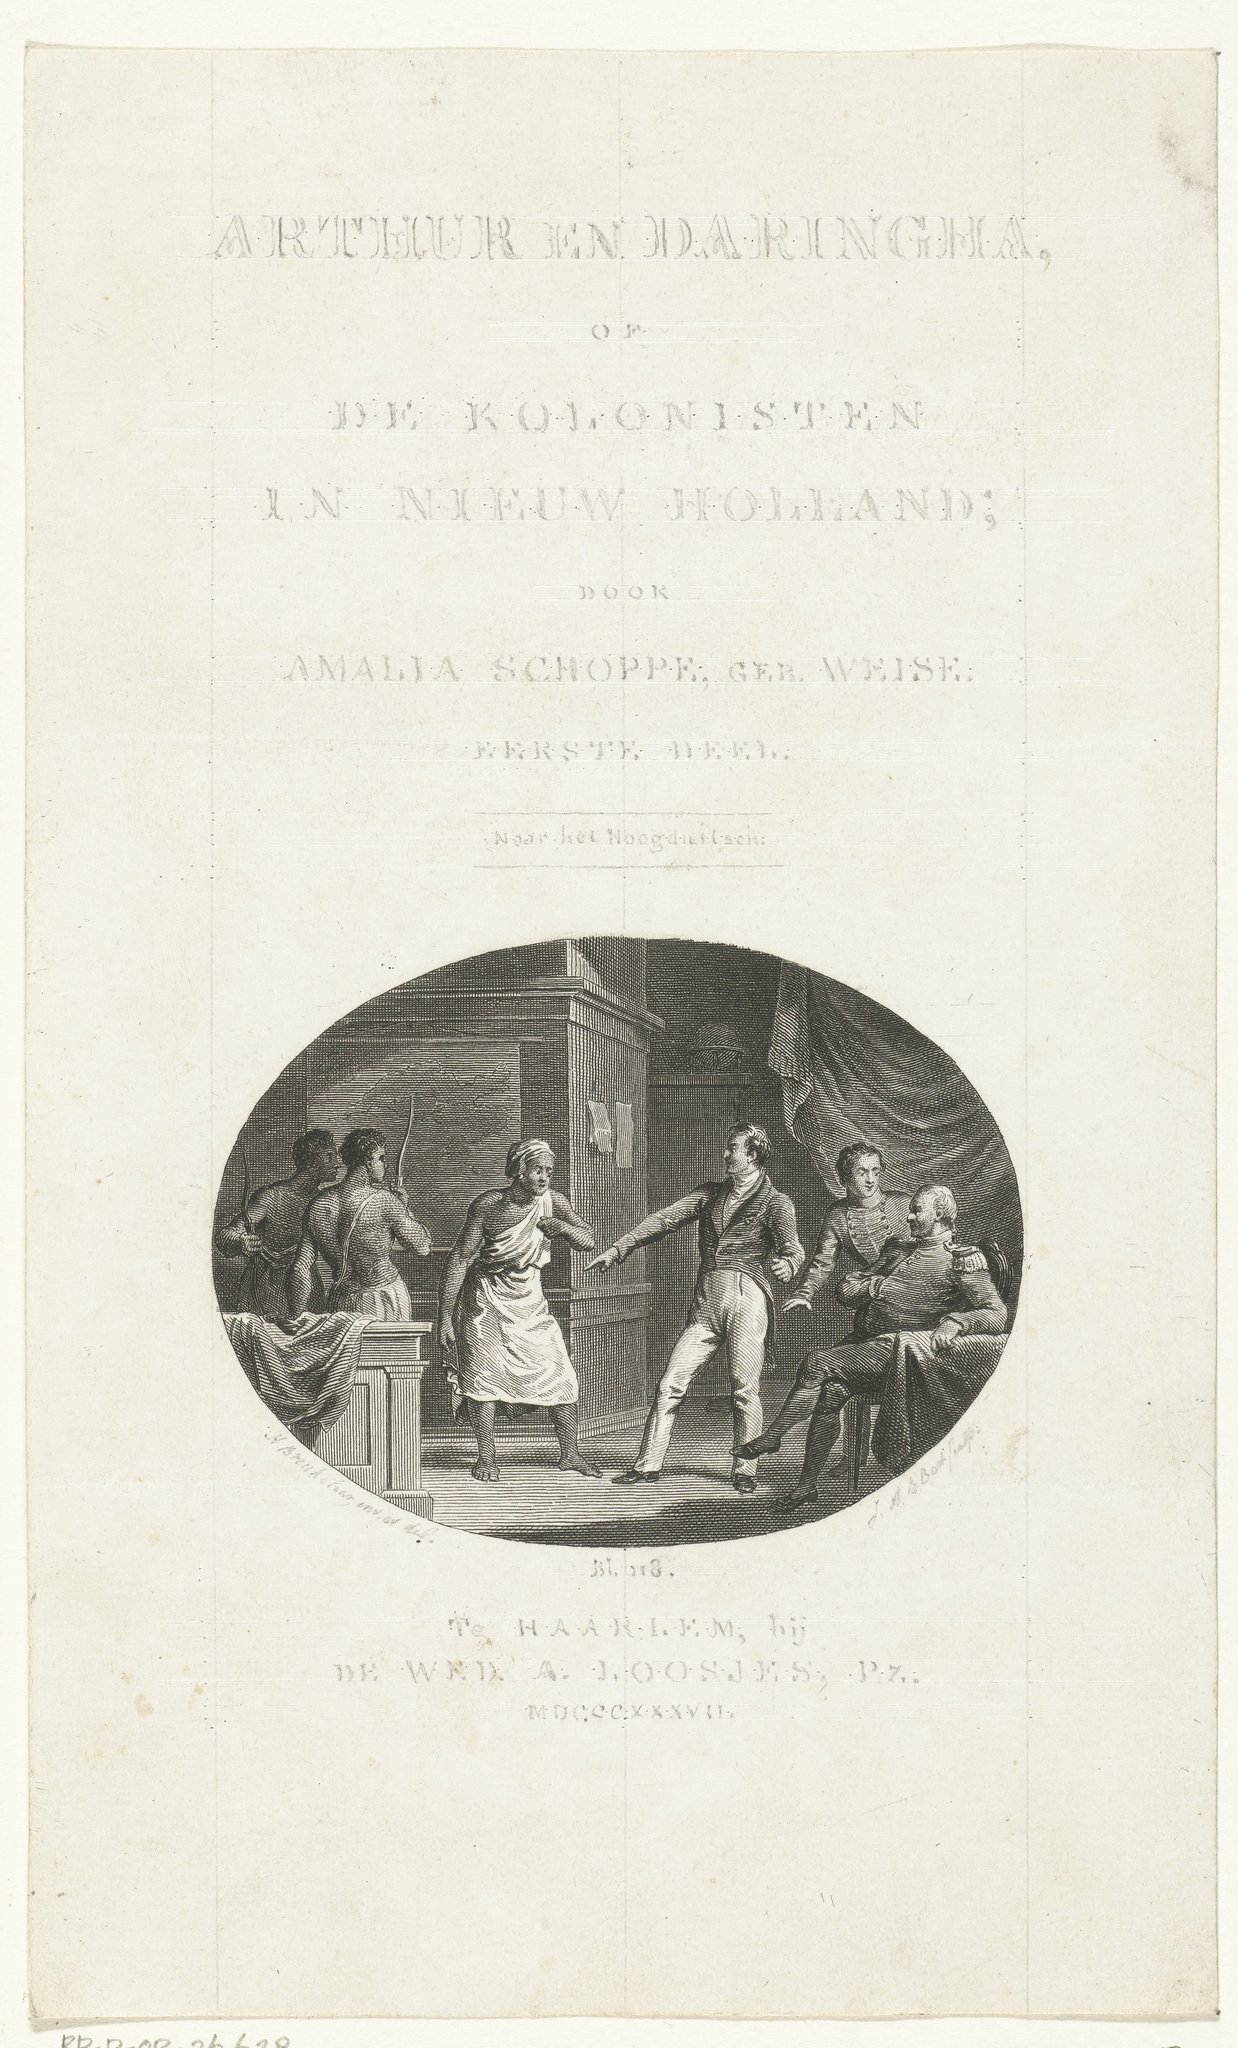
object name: print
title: Kolonisten in gesprek met bewoners van West Australië of Nieuw Holland en opmaak van tekst voor titelpagina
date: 1807-1837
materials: paper, pencil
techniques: etching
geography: amsterdam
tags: colonial government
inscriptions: collector's mark: Lugt 2228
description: Proefdruk voor titelpagina van: Schoppe, Amalia, geb. Weise, Arthur en Daringha of De kolonisten in Nieuw Holland, Wed. A. Loosjes Pz. (uitgever), Haarlem 1837. We kunnen aannemen dat er in ieder geval ook nog een derde staat van deze prent vervaardigd is, de titelpagina compleet met tekst.